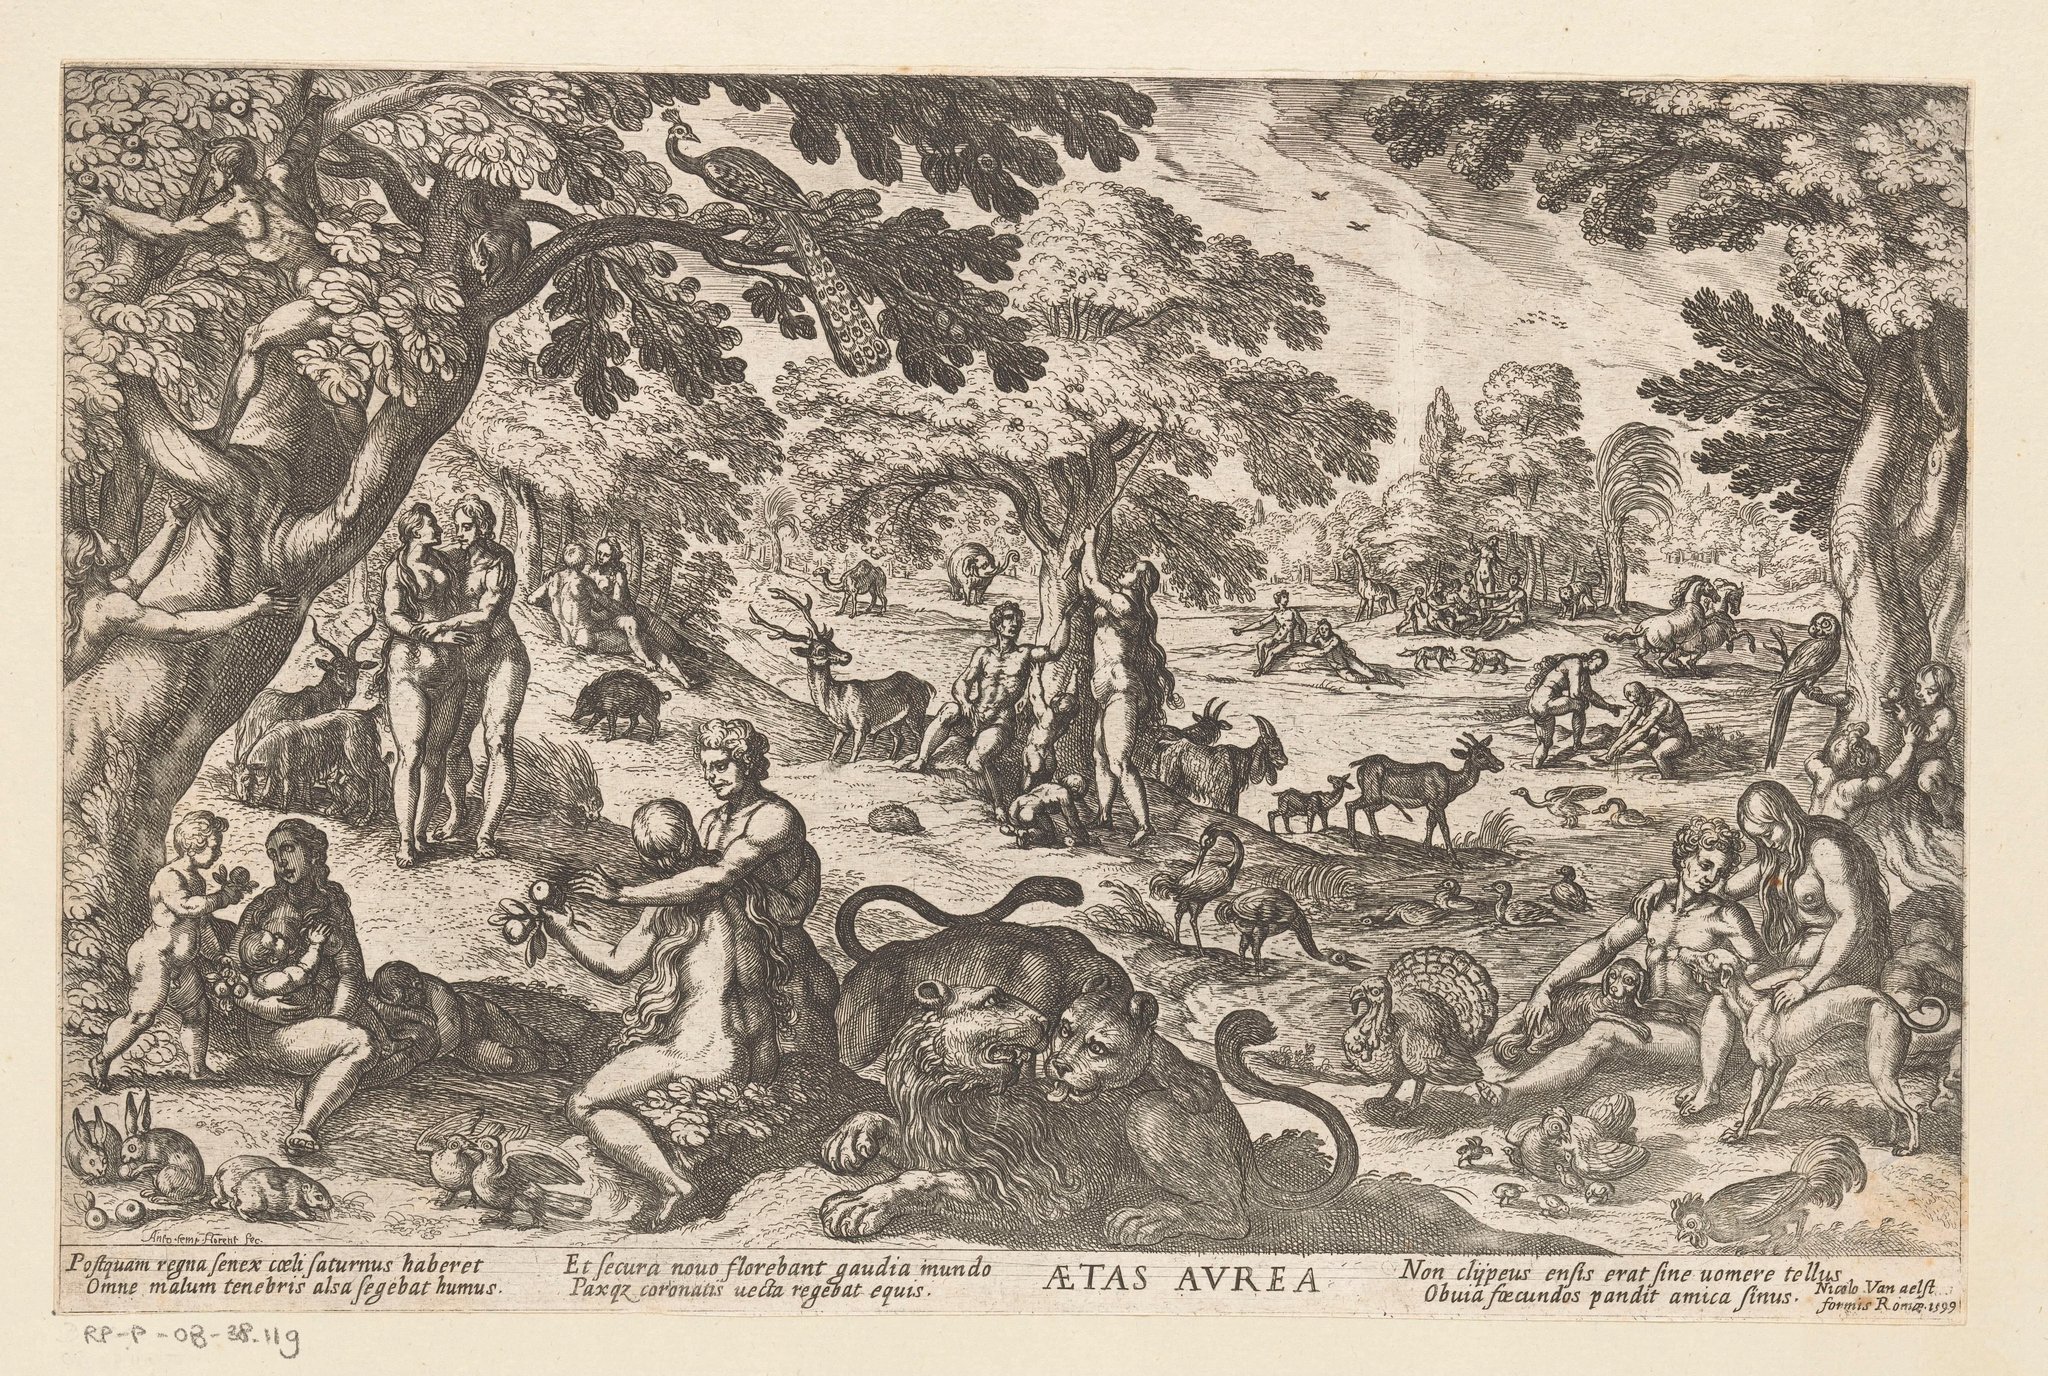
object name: print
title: Aetas aurea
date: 1599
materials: paper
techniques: etching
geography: rome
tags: the golden age, 'aetas aurea'; men live happily, gathering fruits under the reign of saturn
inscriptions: collector's mark: Lugt 240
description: Het gouden tijdperk: mensen en dieren leven gelukkig in een paradijselijk landschap. Onderschrift en titel in het Latijn in ondermarge.